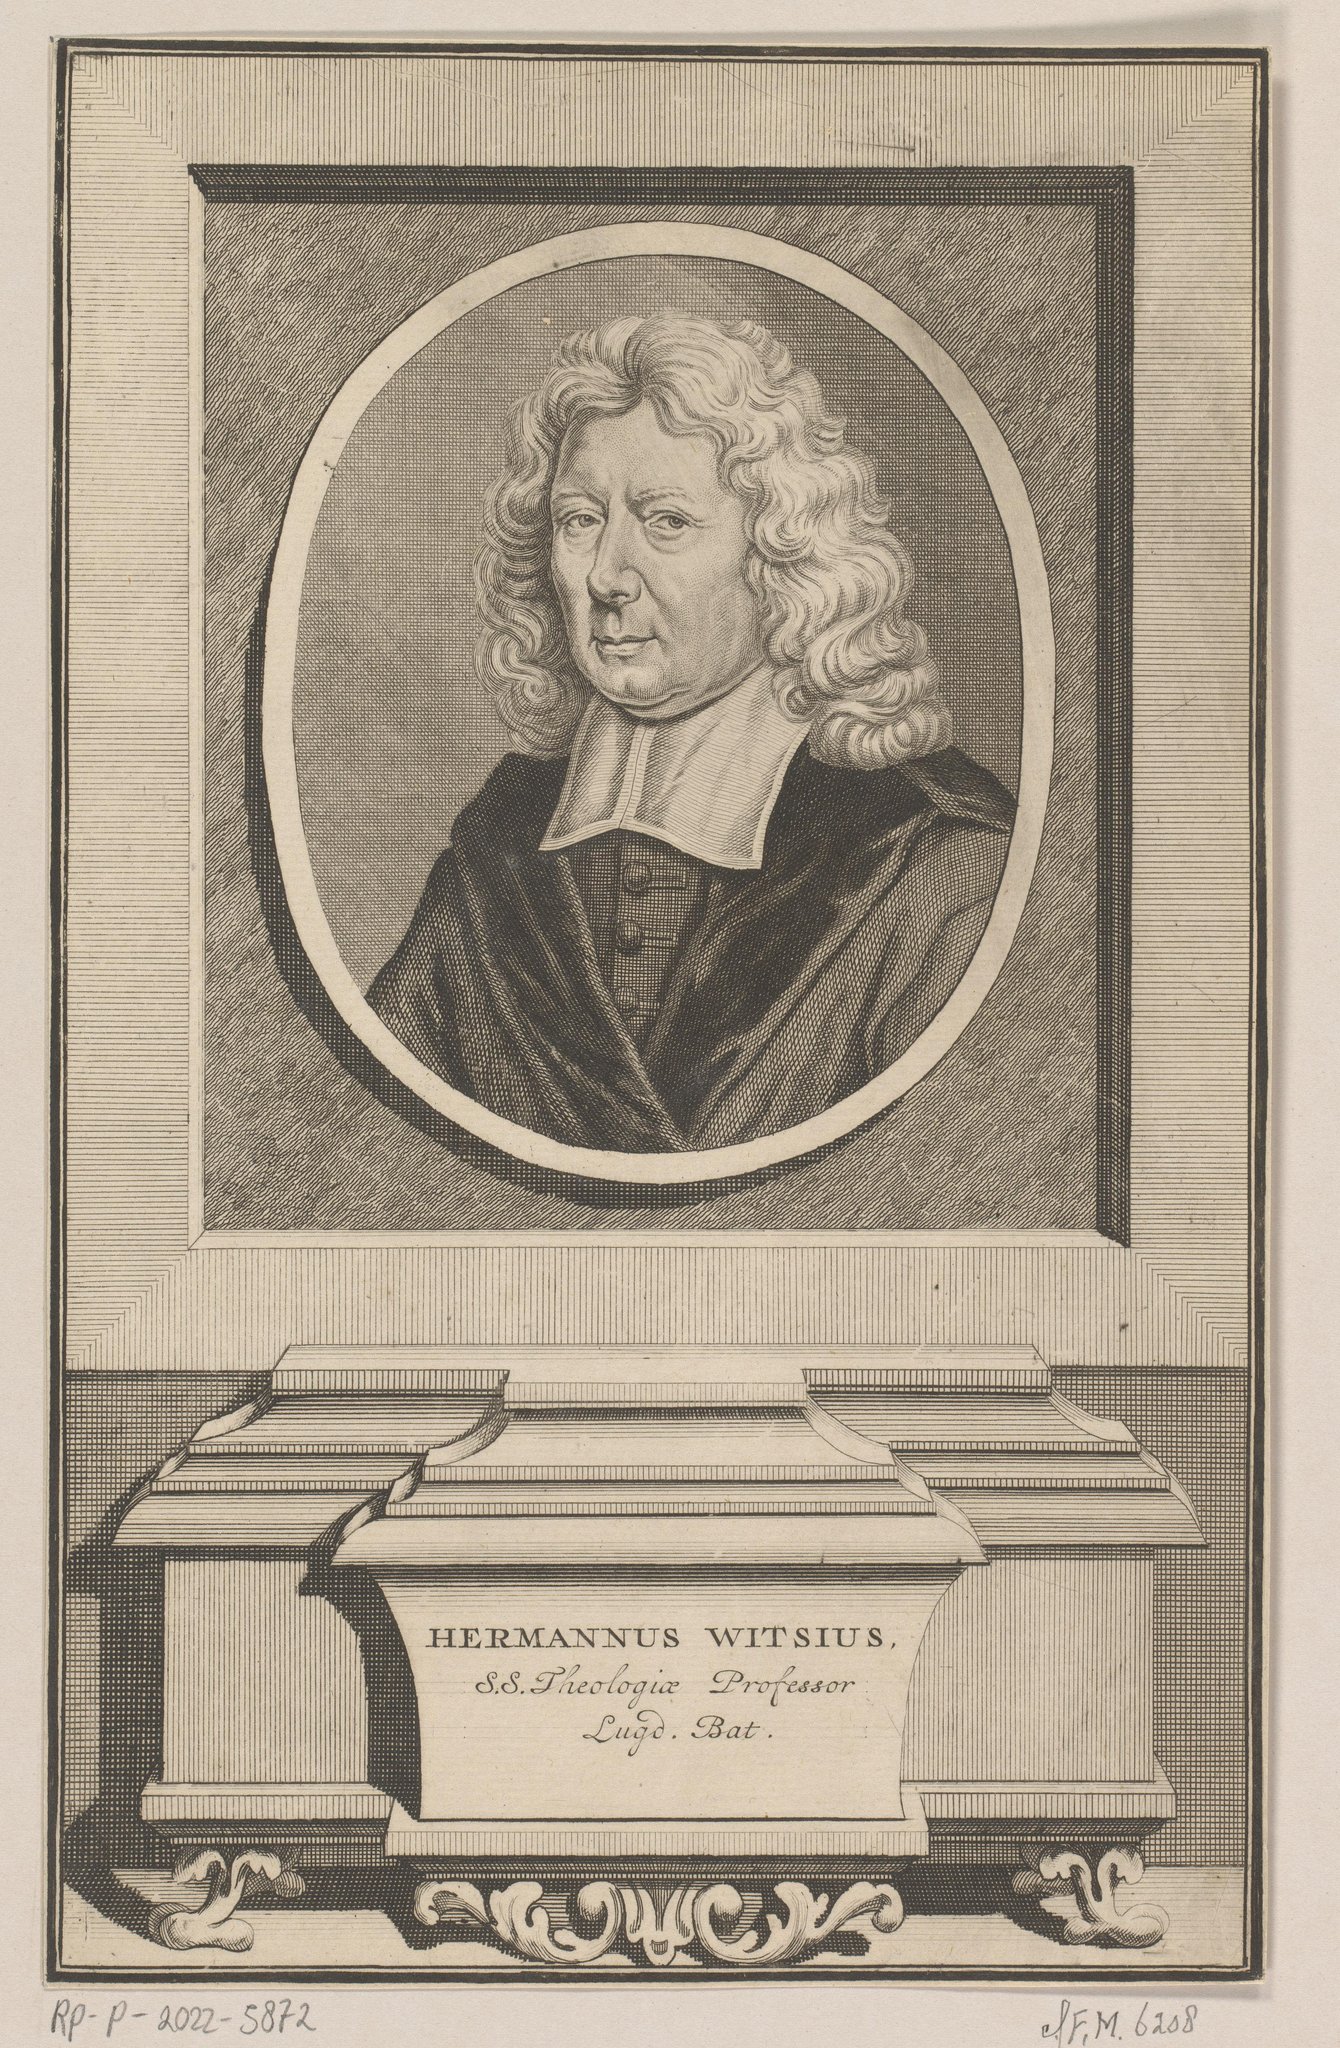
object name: print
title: Fundatoris, curatorum et professorum celeberrimorum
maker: Anonymous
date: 1716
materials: paper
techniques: engraving, etching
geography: low countries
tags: enkhuizen, leiden, herman witsius, historical persons, professor, functionaries and dignitaries ~ protestant churches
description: Prent waarschijnlijk uit: Fundatoris, curatorum et professorum celeberrimorum, aliorumque illustrium virorum (...). Leiden: Pieter van der Aa, 1720.